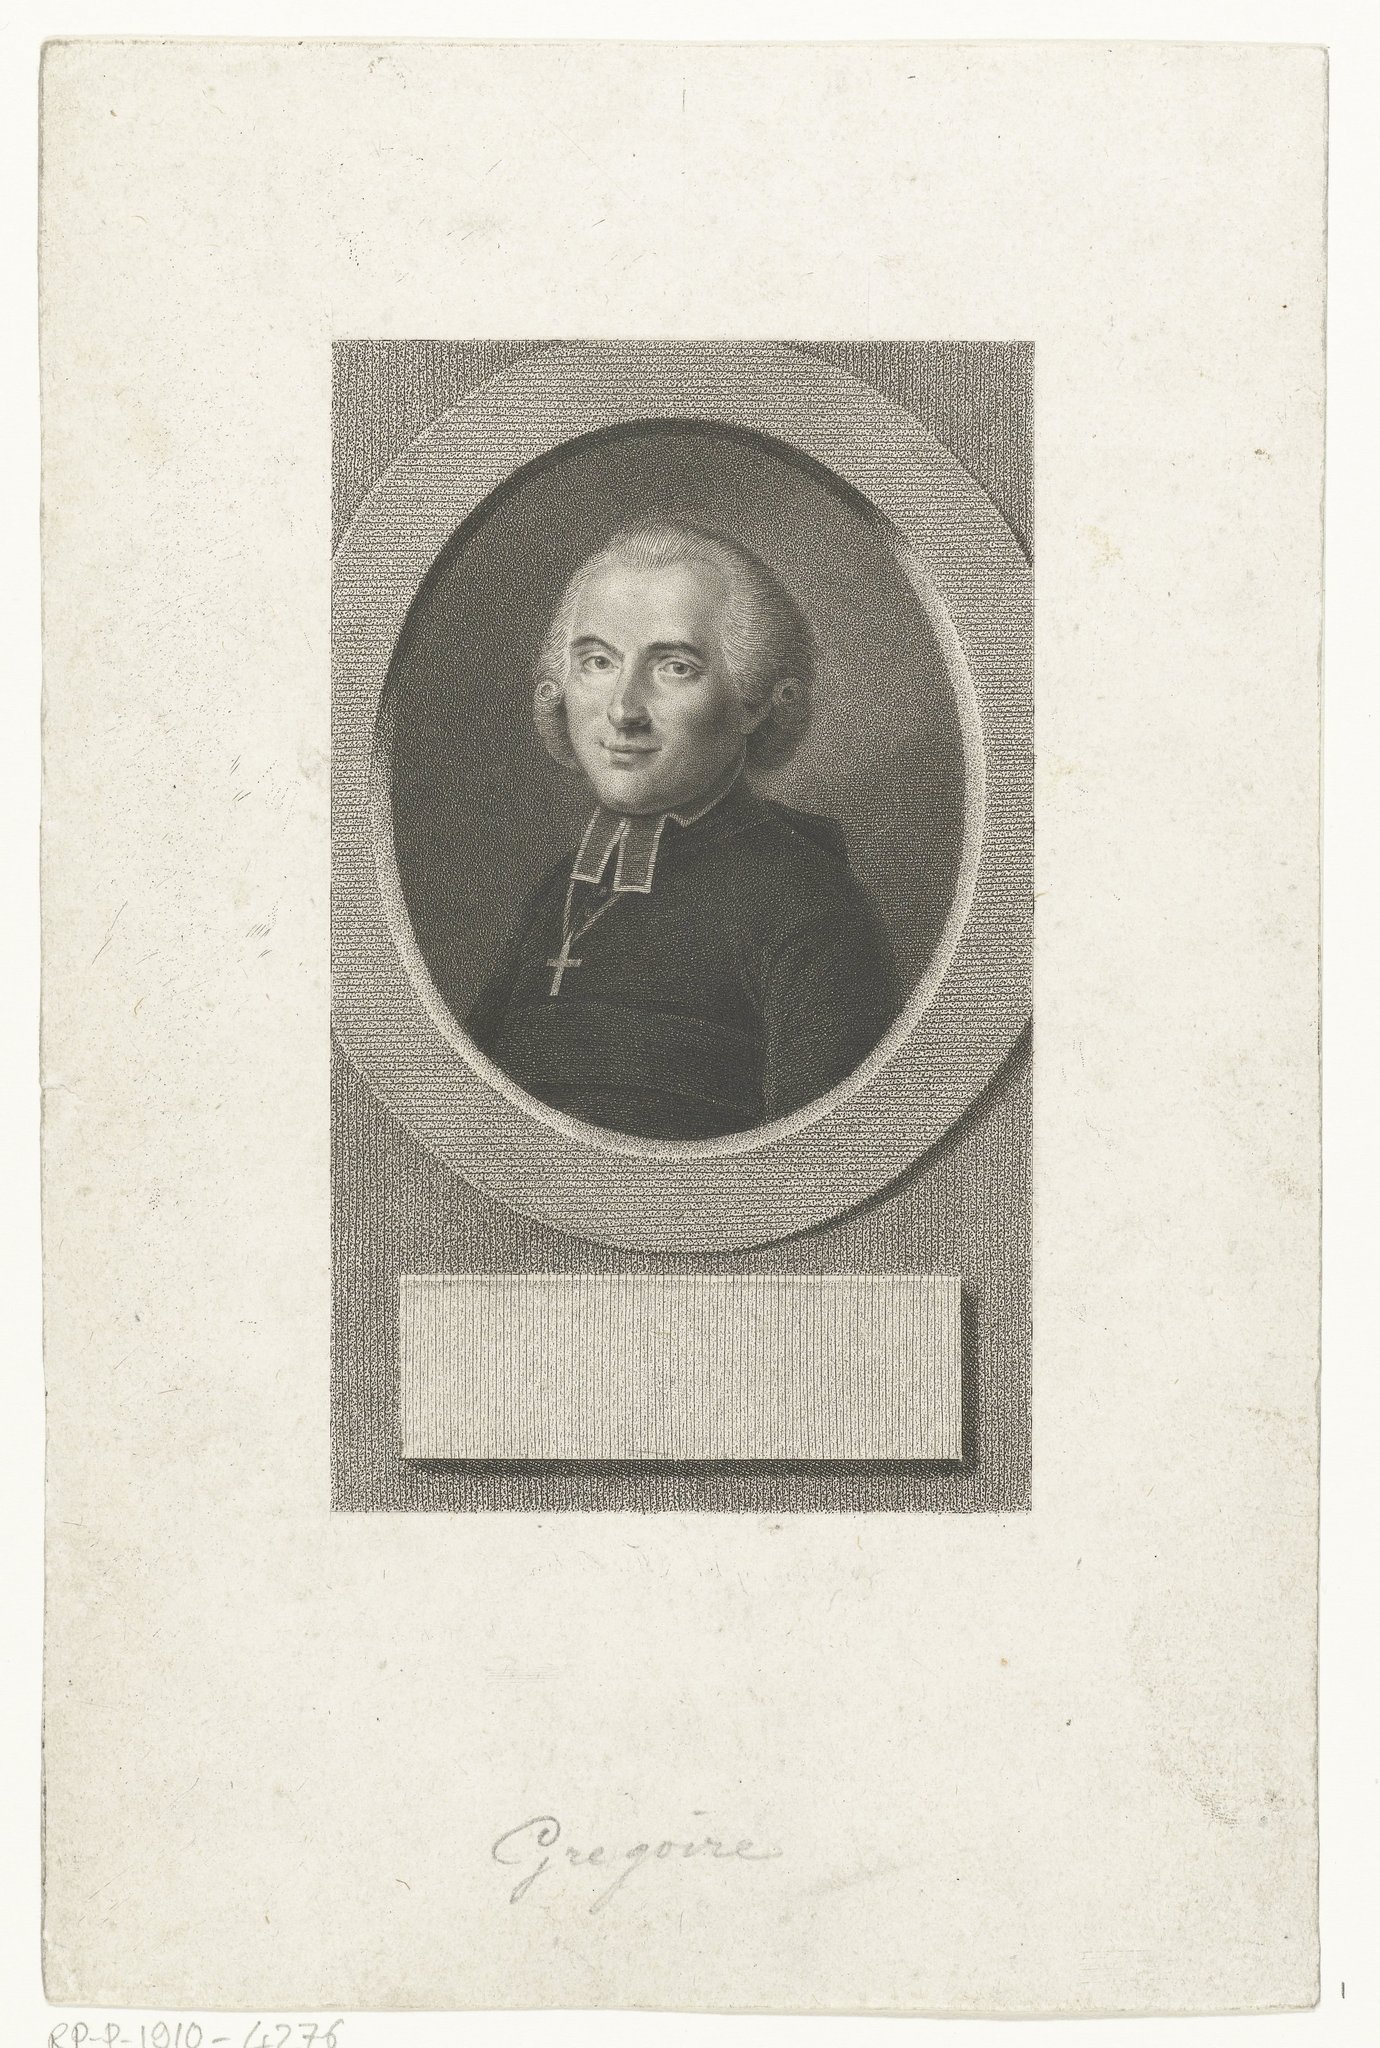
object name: print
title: Portret van Henri Grégoire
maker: lambertus antonius claessens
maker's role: draughtsman, print maker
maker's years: 1763-1834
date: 1792-1808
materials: paper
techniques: engraving, etching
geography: amsterdam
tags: priest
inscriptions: collector's mark: Lugt 2228